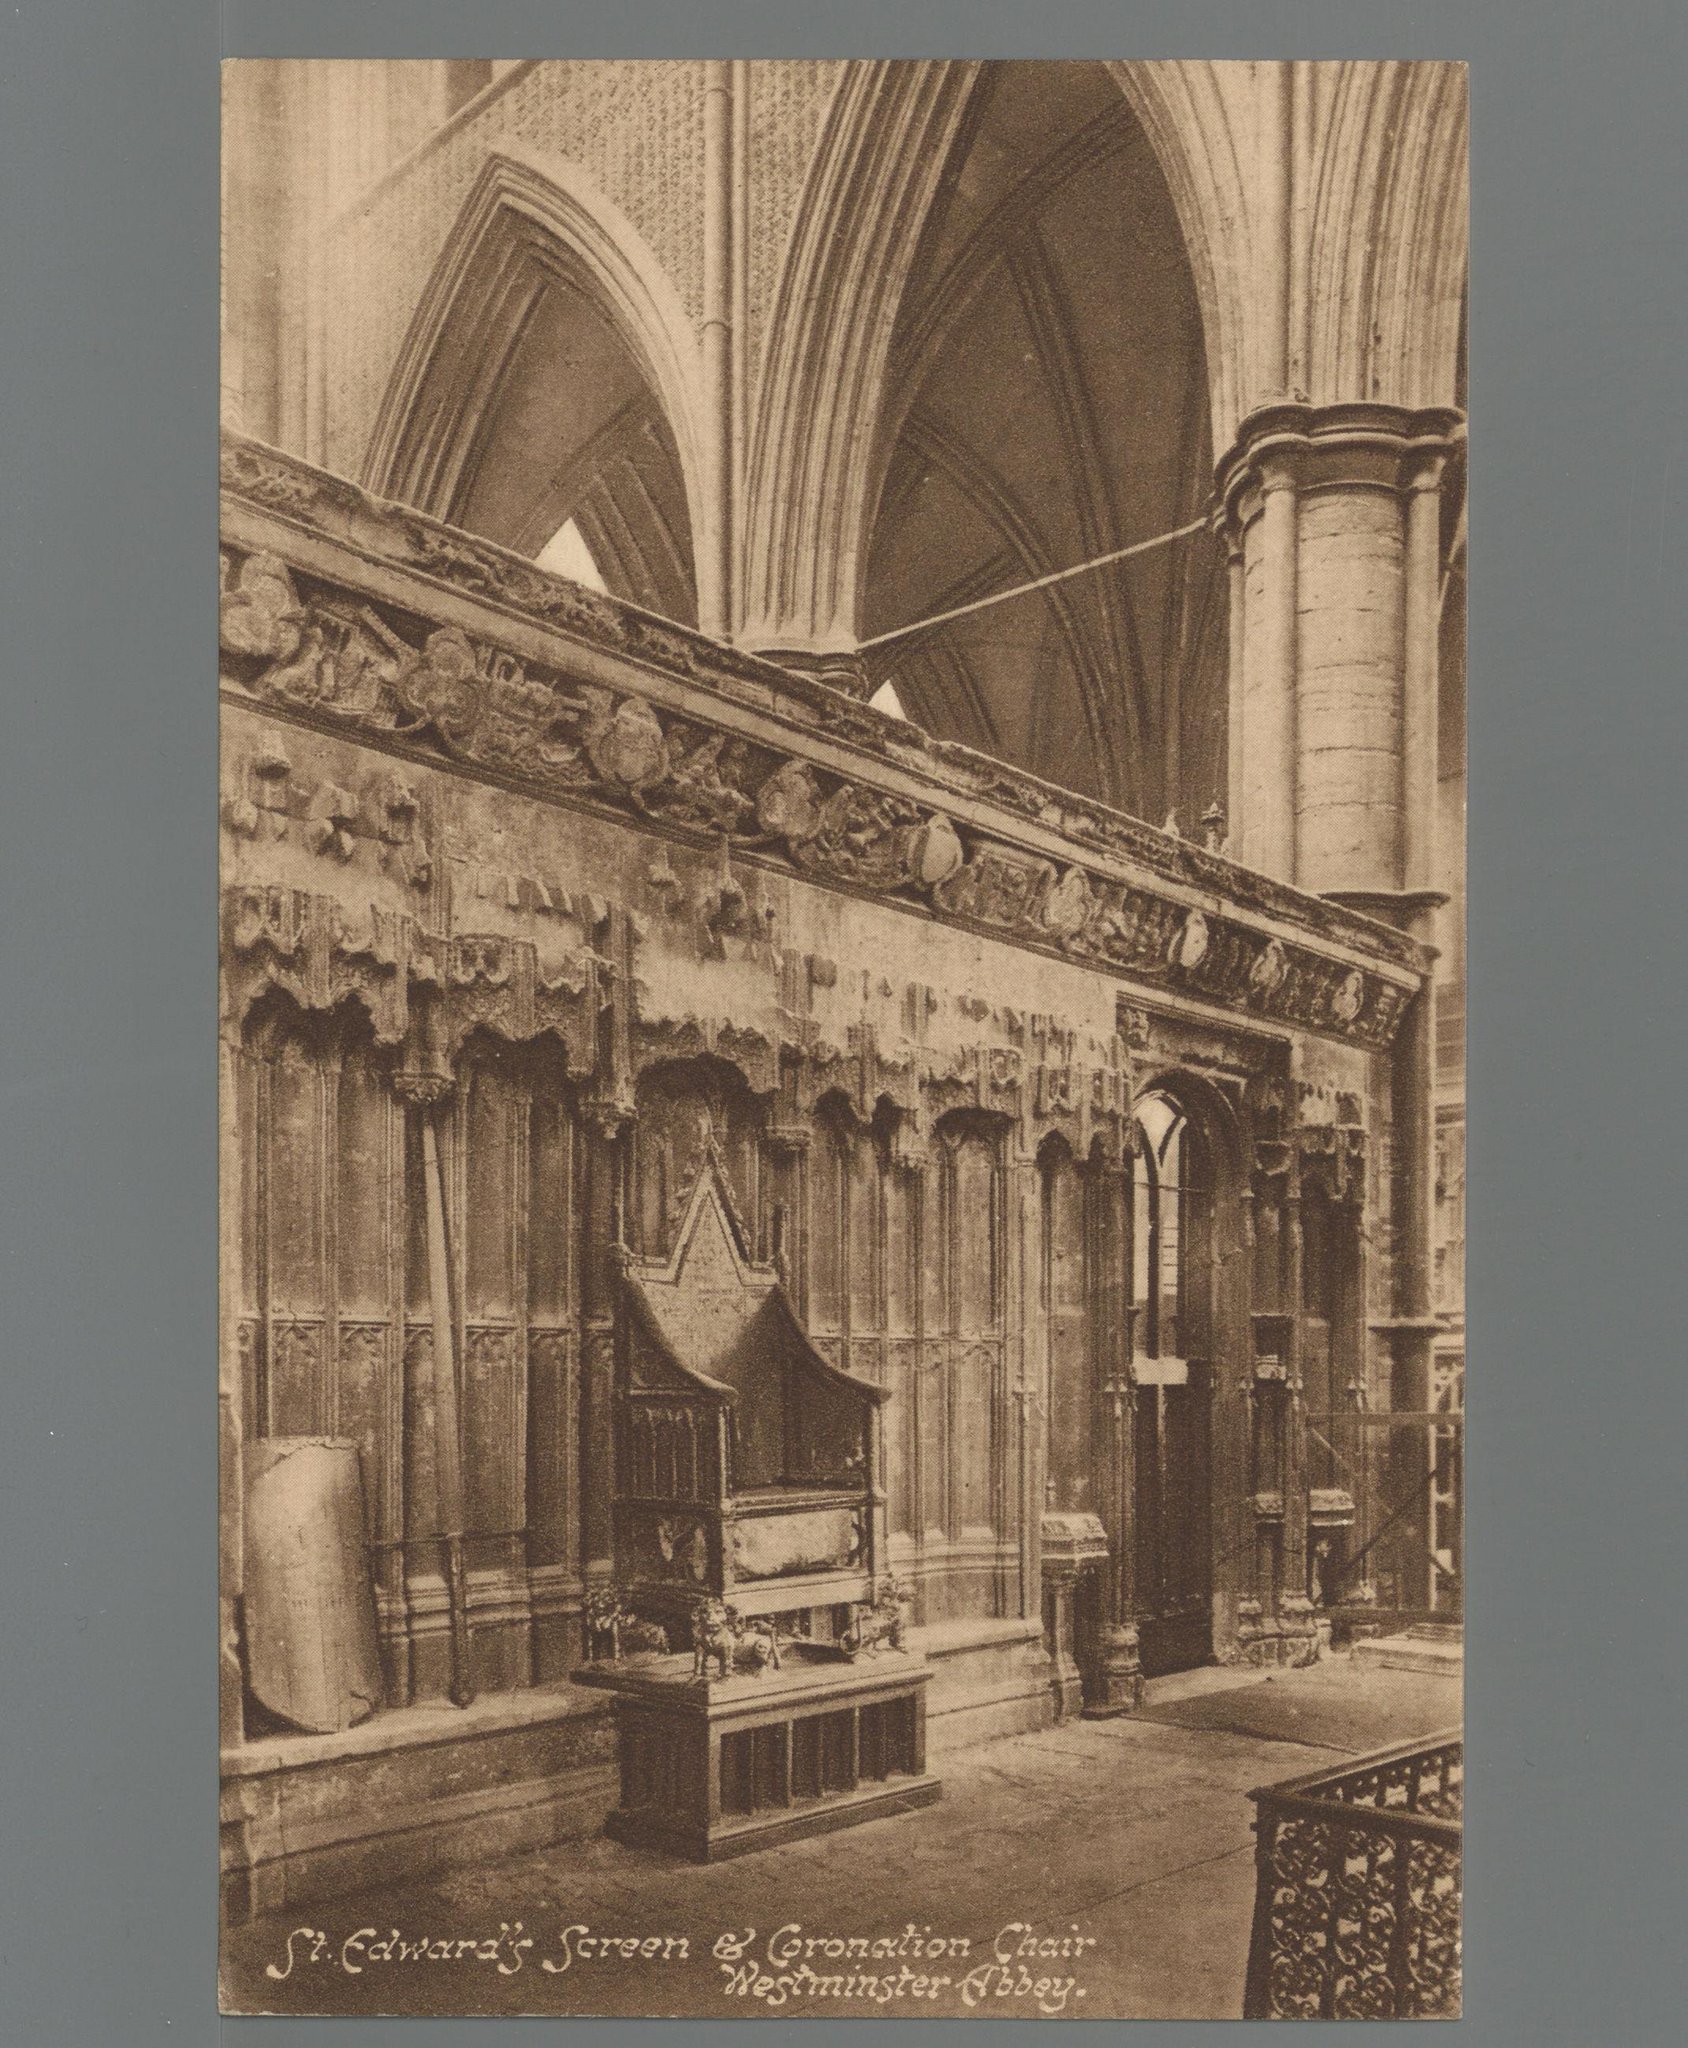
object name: ansichtkaart, prentbriefkaart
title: Valentine's Gravure Series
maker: Anonymous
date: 1902-1930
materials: cardboard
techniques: rotogravure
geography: london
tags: armchair, seat, interior of church, westminster abbey